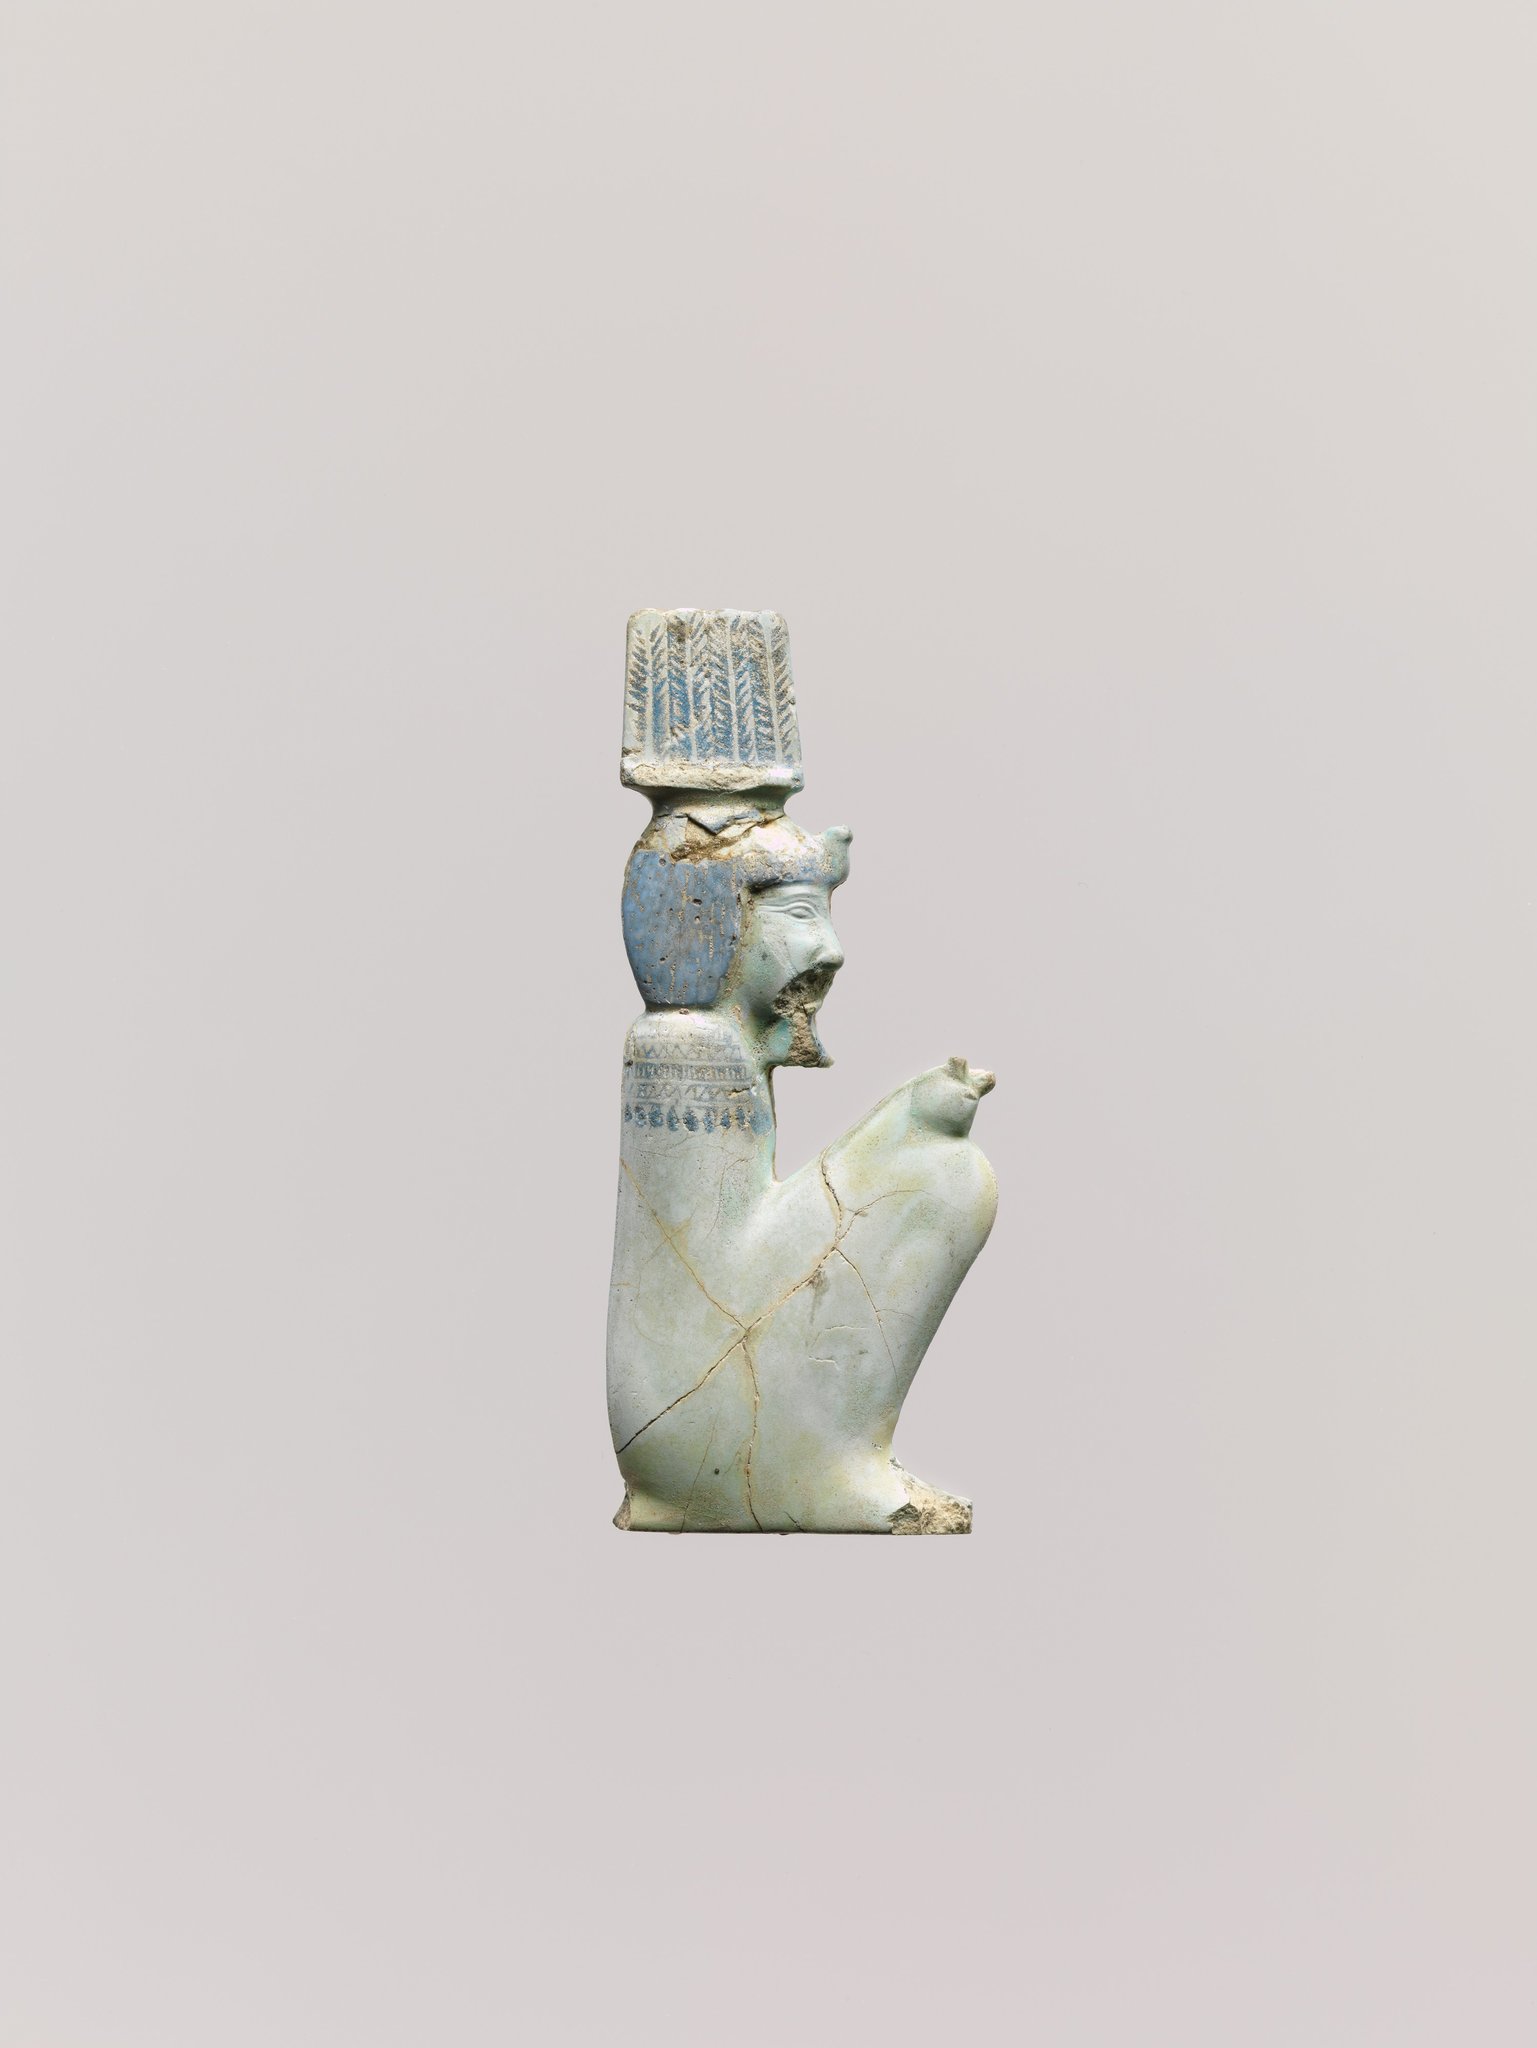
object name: inlay, squatting figure, anhur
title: Inlay depicting the squatting god Anhur (Onuris) facing right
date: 400-301 BCE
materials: faience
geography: egypt